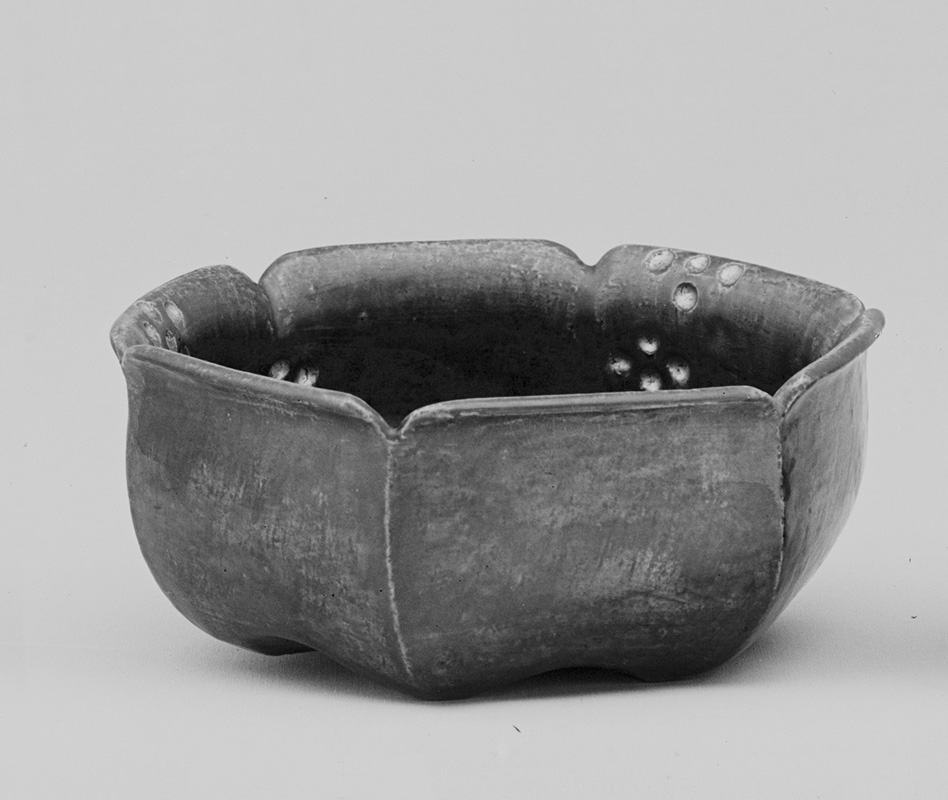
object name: bowl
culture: japanese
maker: toyosuke iv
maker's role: artist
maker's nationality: japanese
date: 1840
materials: glaze, pottery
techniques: enamel, overglaze